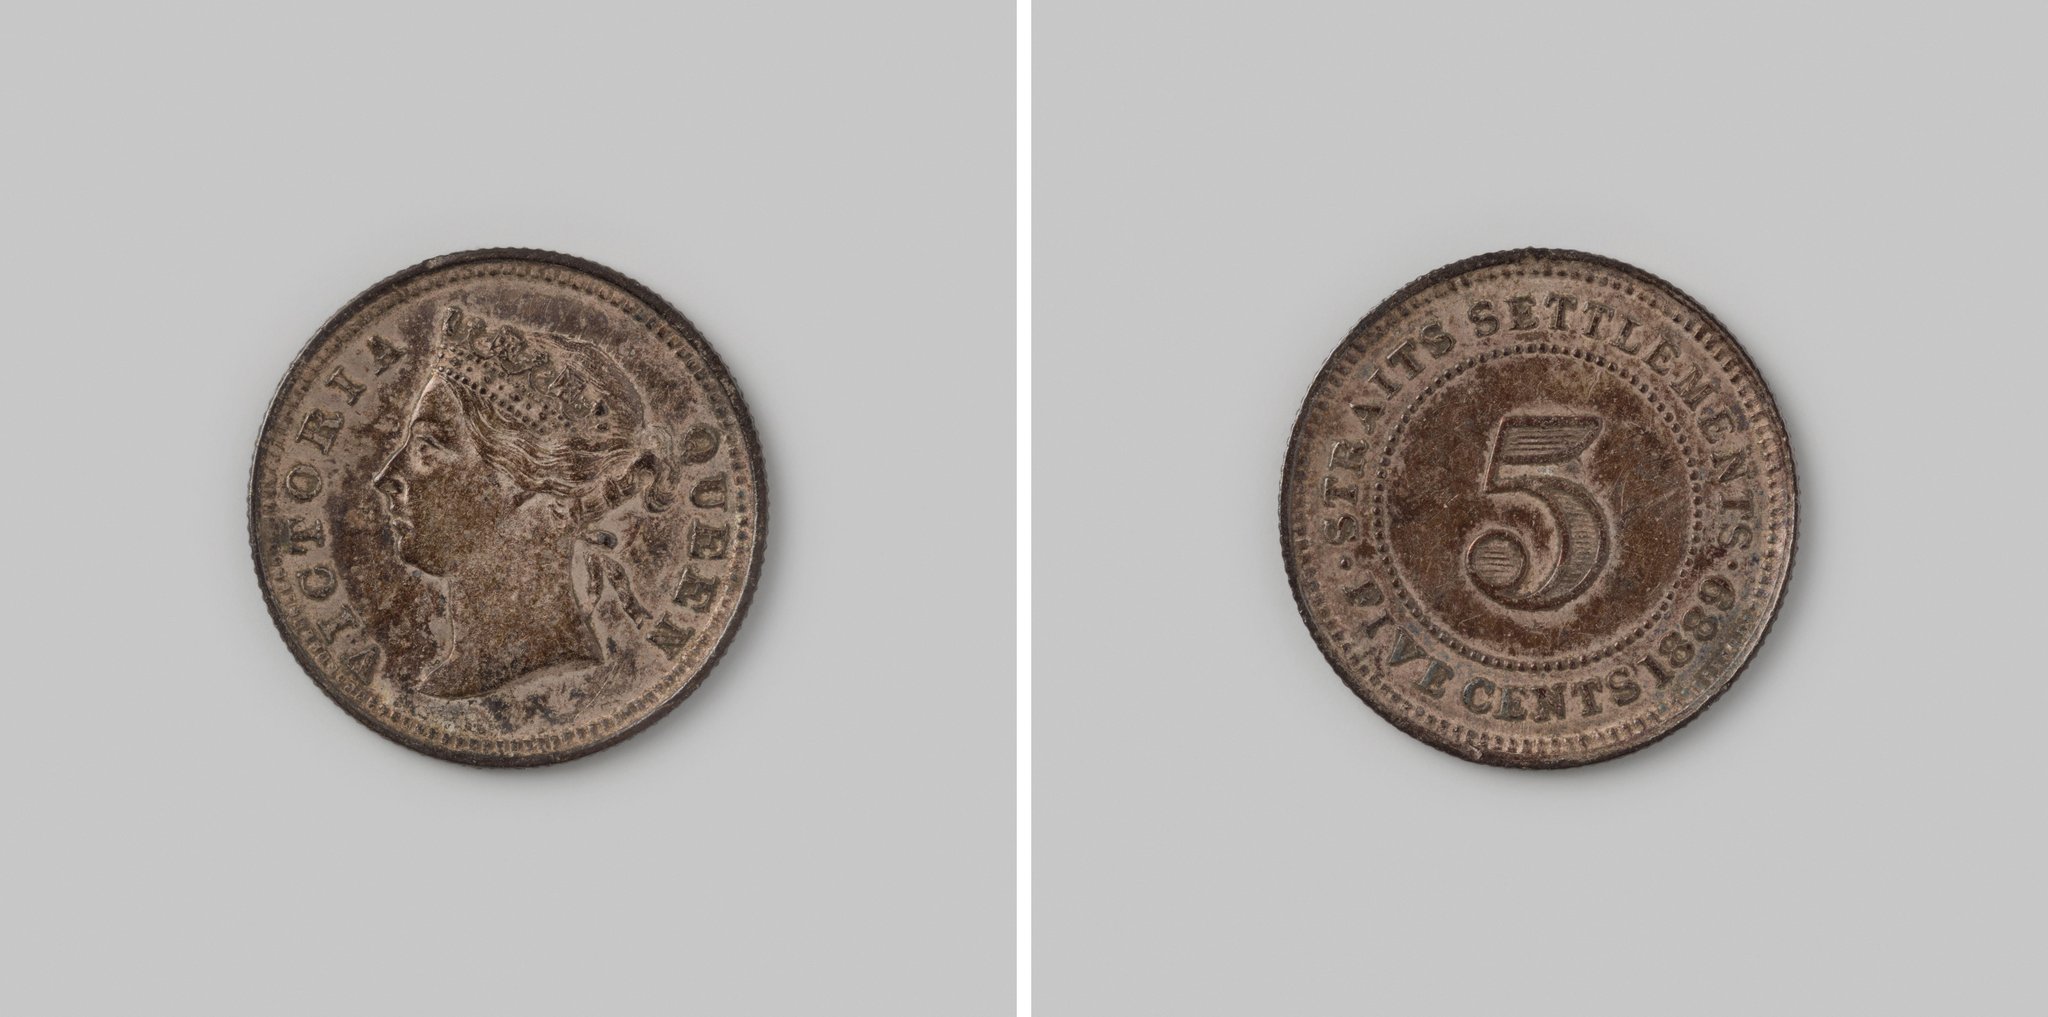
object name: coin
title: 5 cents uit de Straits Settlements van koningin Victoria, 1889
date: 1889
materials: silver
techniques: striking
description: Zilveren munt. Voorzijde: gekroond hoofd van koningin Victoria naar links. Keerzijde: binnen parelcirkel waarde-aanduiding: 5. In omschrift onderaan waarde-aanduiding: five cents met rechts daarvan jaartal. Kartelrand.